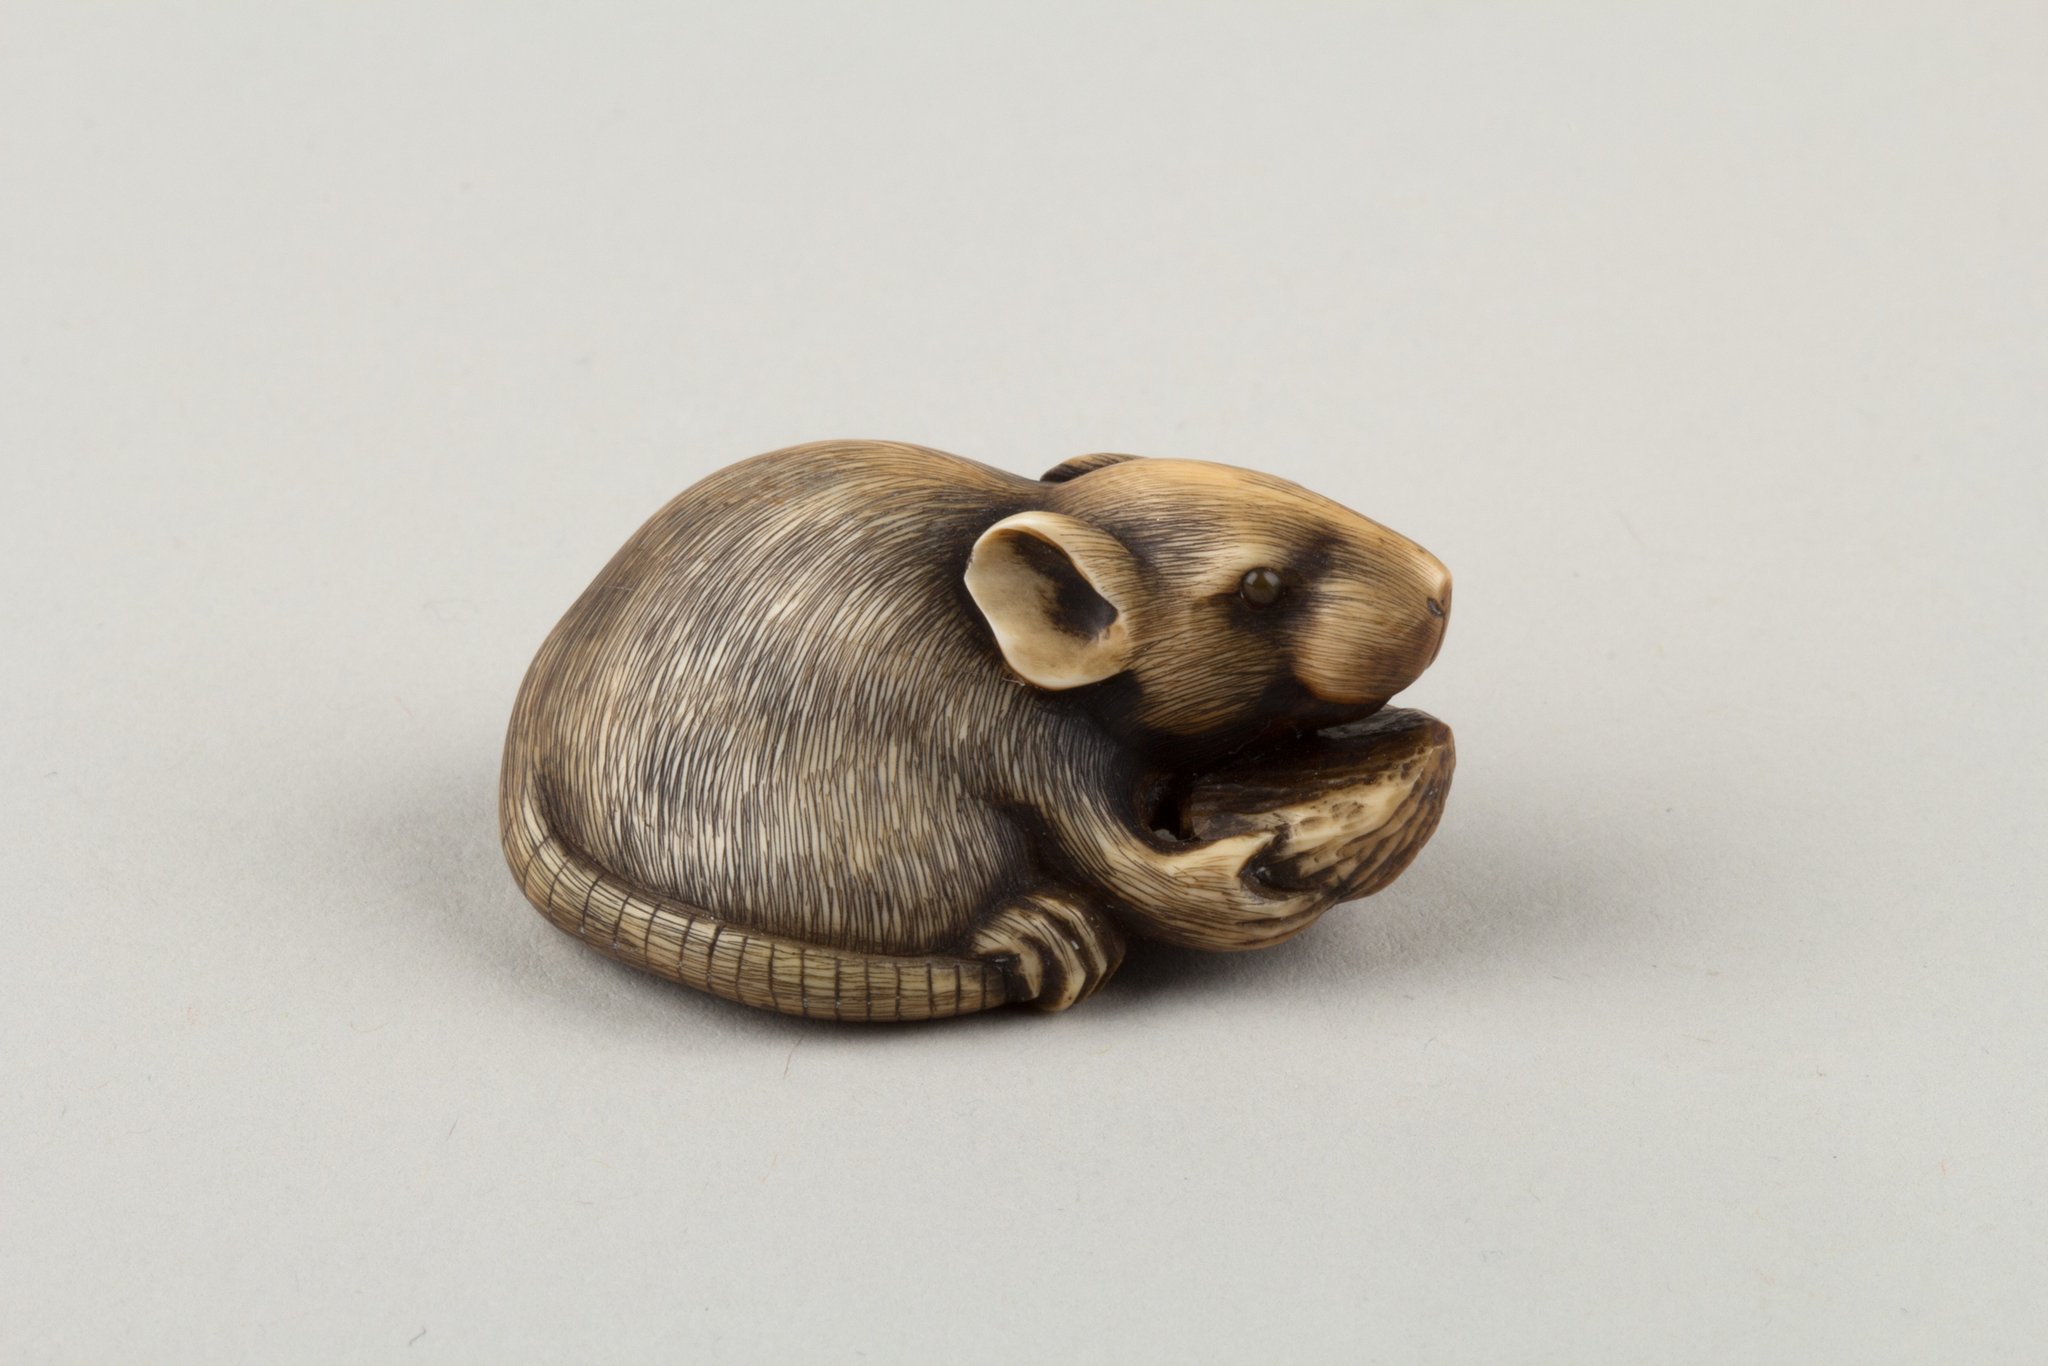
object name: netsuke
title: Mouse Eating a Pit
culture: japanese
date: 1801-1900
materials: ivory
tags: mice